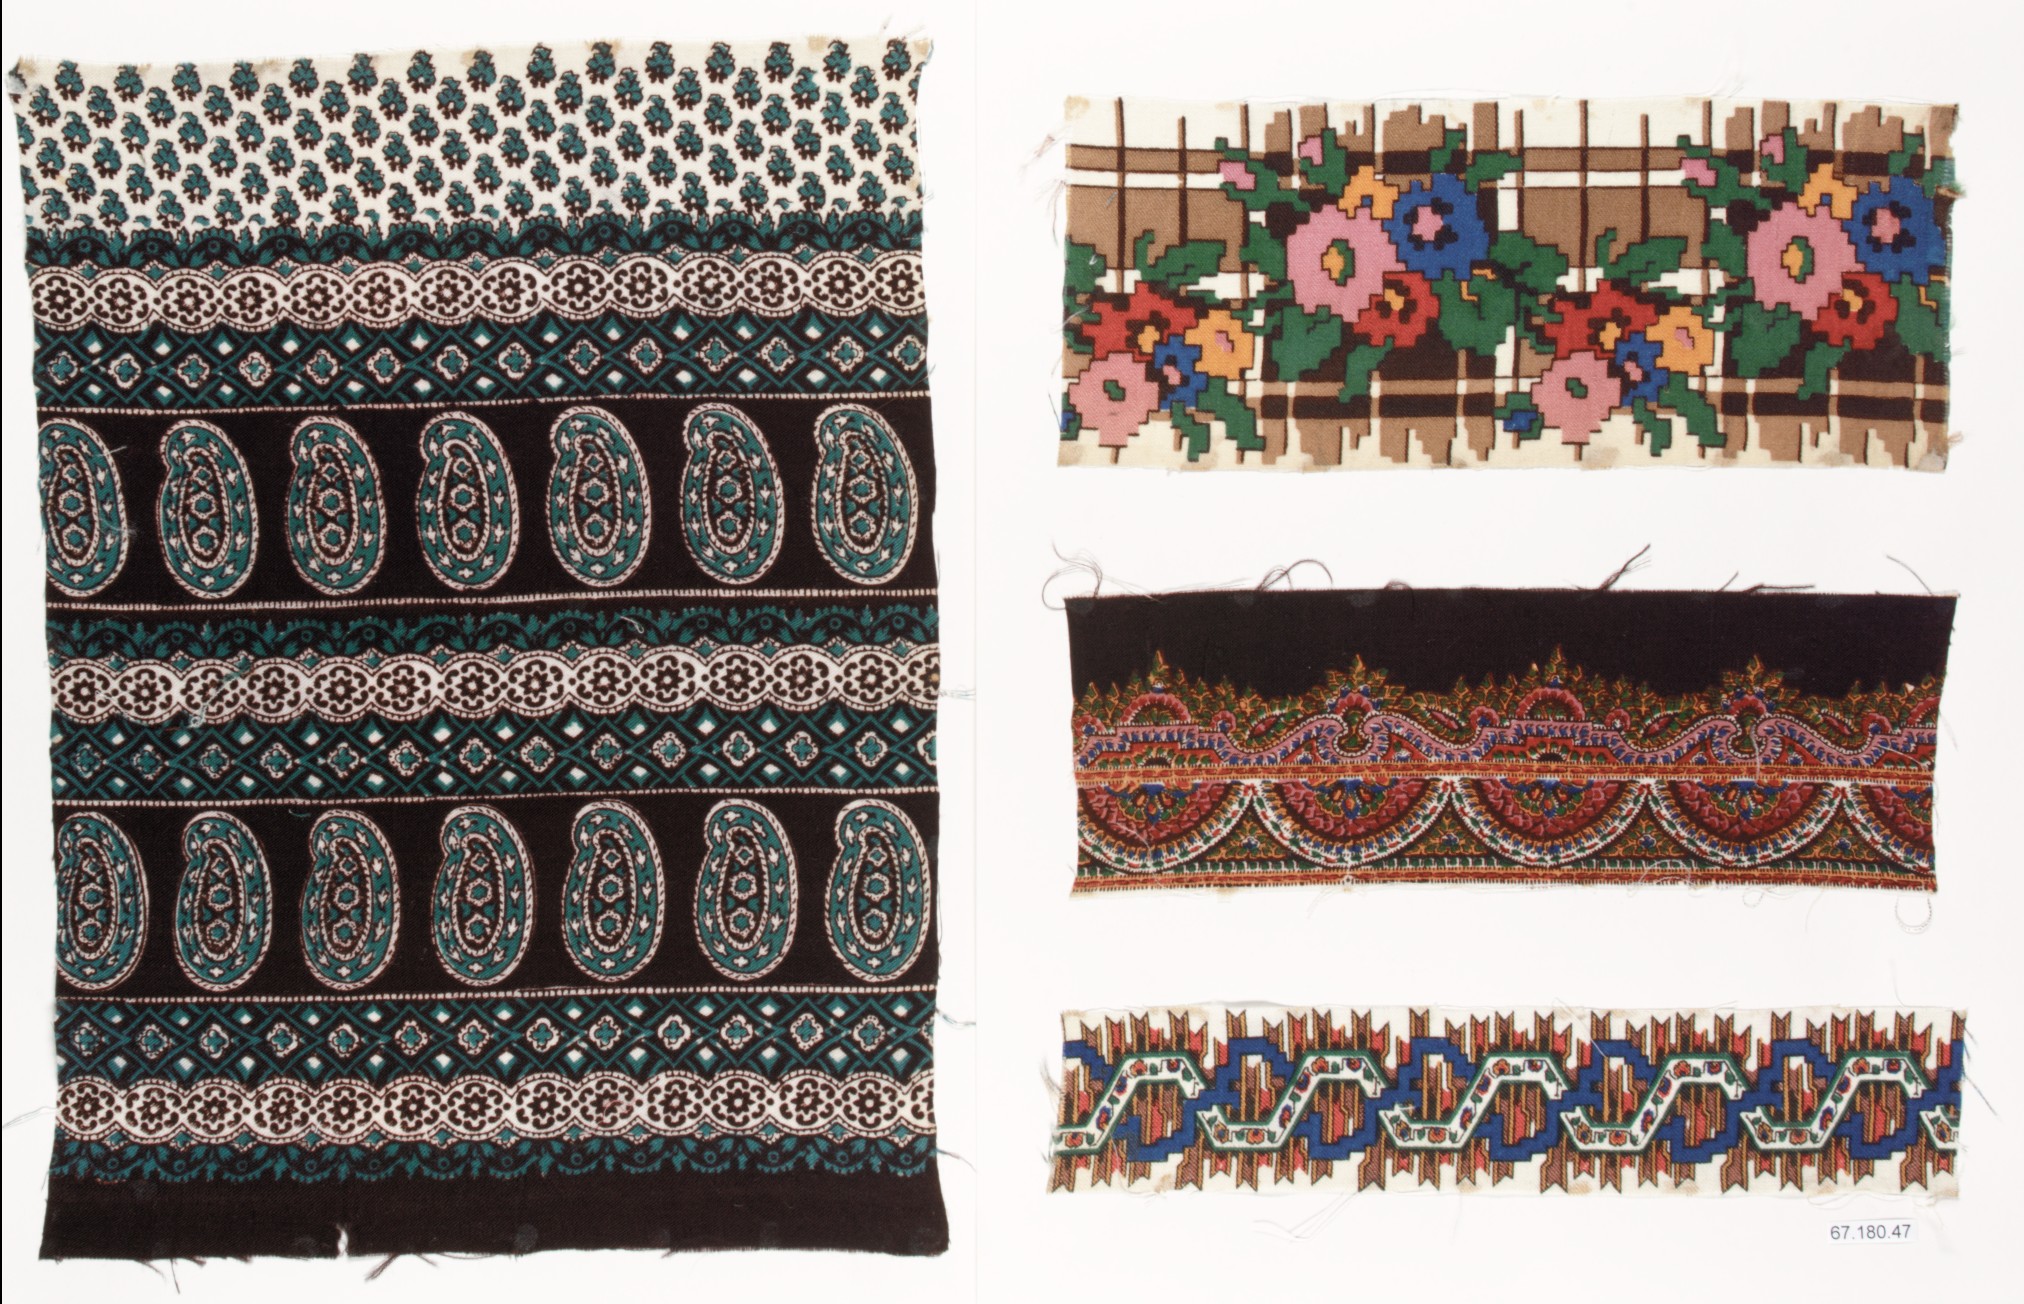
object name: sample book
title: Petits Pékins (346 pages of textile samples)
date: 1890-1899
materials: cotton, leather, silk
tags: flowers